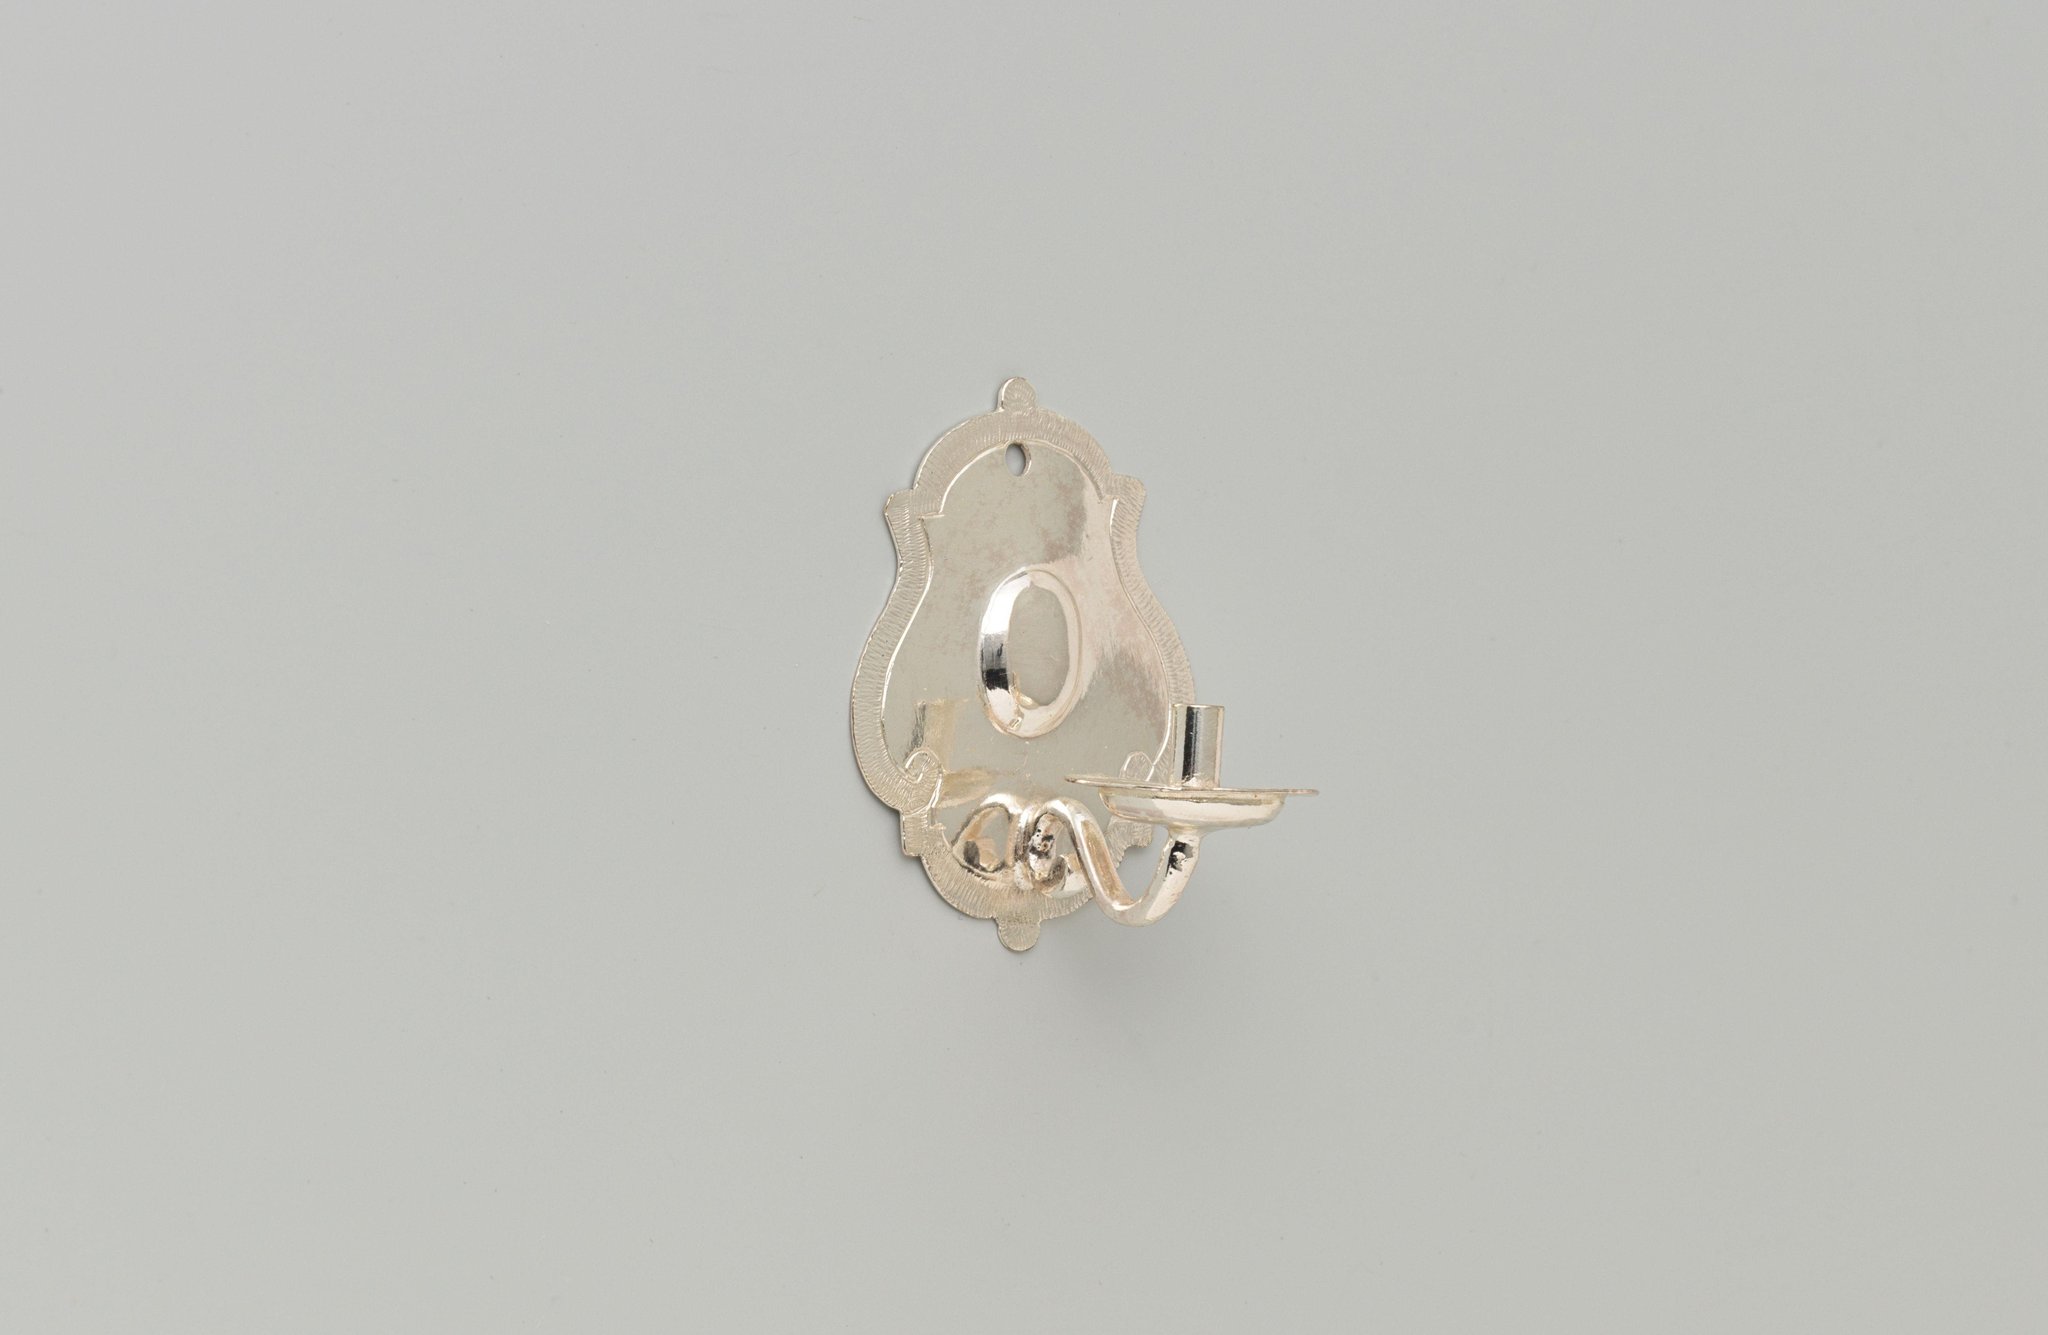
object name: sconce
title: Wandarm van zilver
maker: willem van strant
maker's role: silversmith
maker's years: 1682-1742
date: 1727-1742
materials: silver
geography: amsterdam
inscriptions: maker's mark: ‘VS (Citroen, nr. 899)’, town mark: ‘kleine stadskeur Amsterdam’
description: Wandarm van zilver, schildvormige wandplaat met centraal ovaal, met in en uitzwenkende omtrek met getrembleerde rand. S-vormige arm met gladde ronde kaarshouder en vetvanger. Hierbij hoort een tweede exemplaar (B).